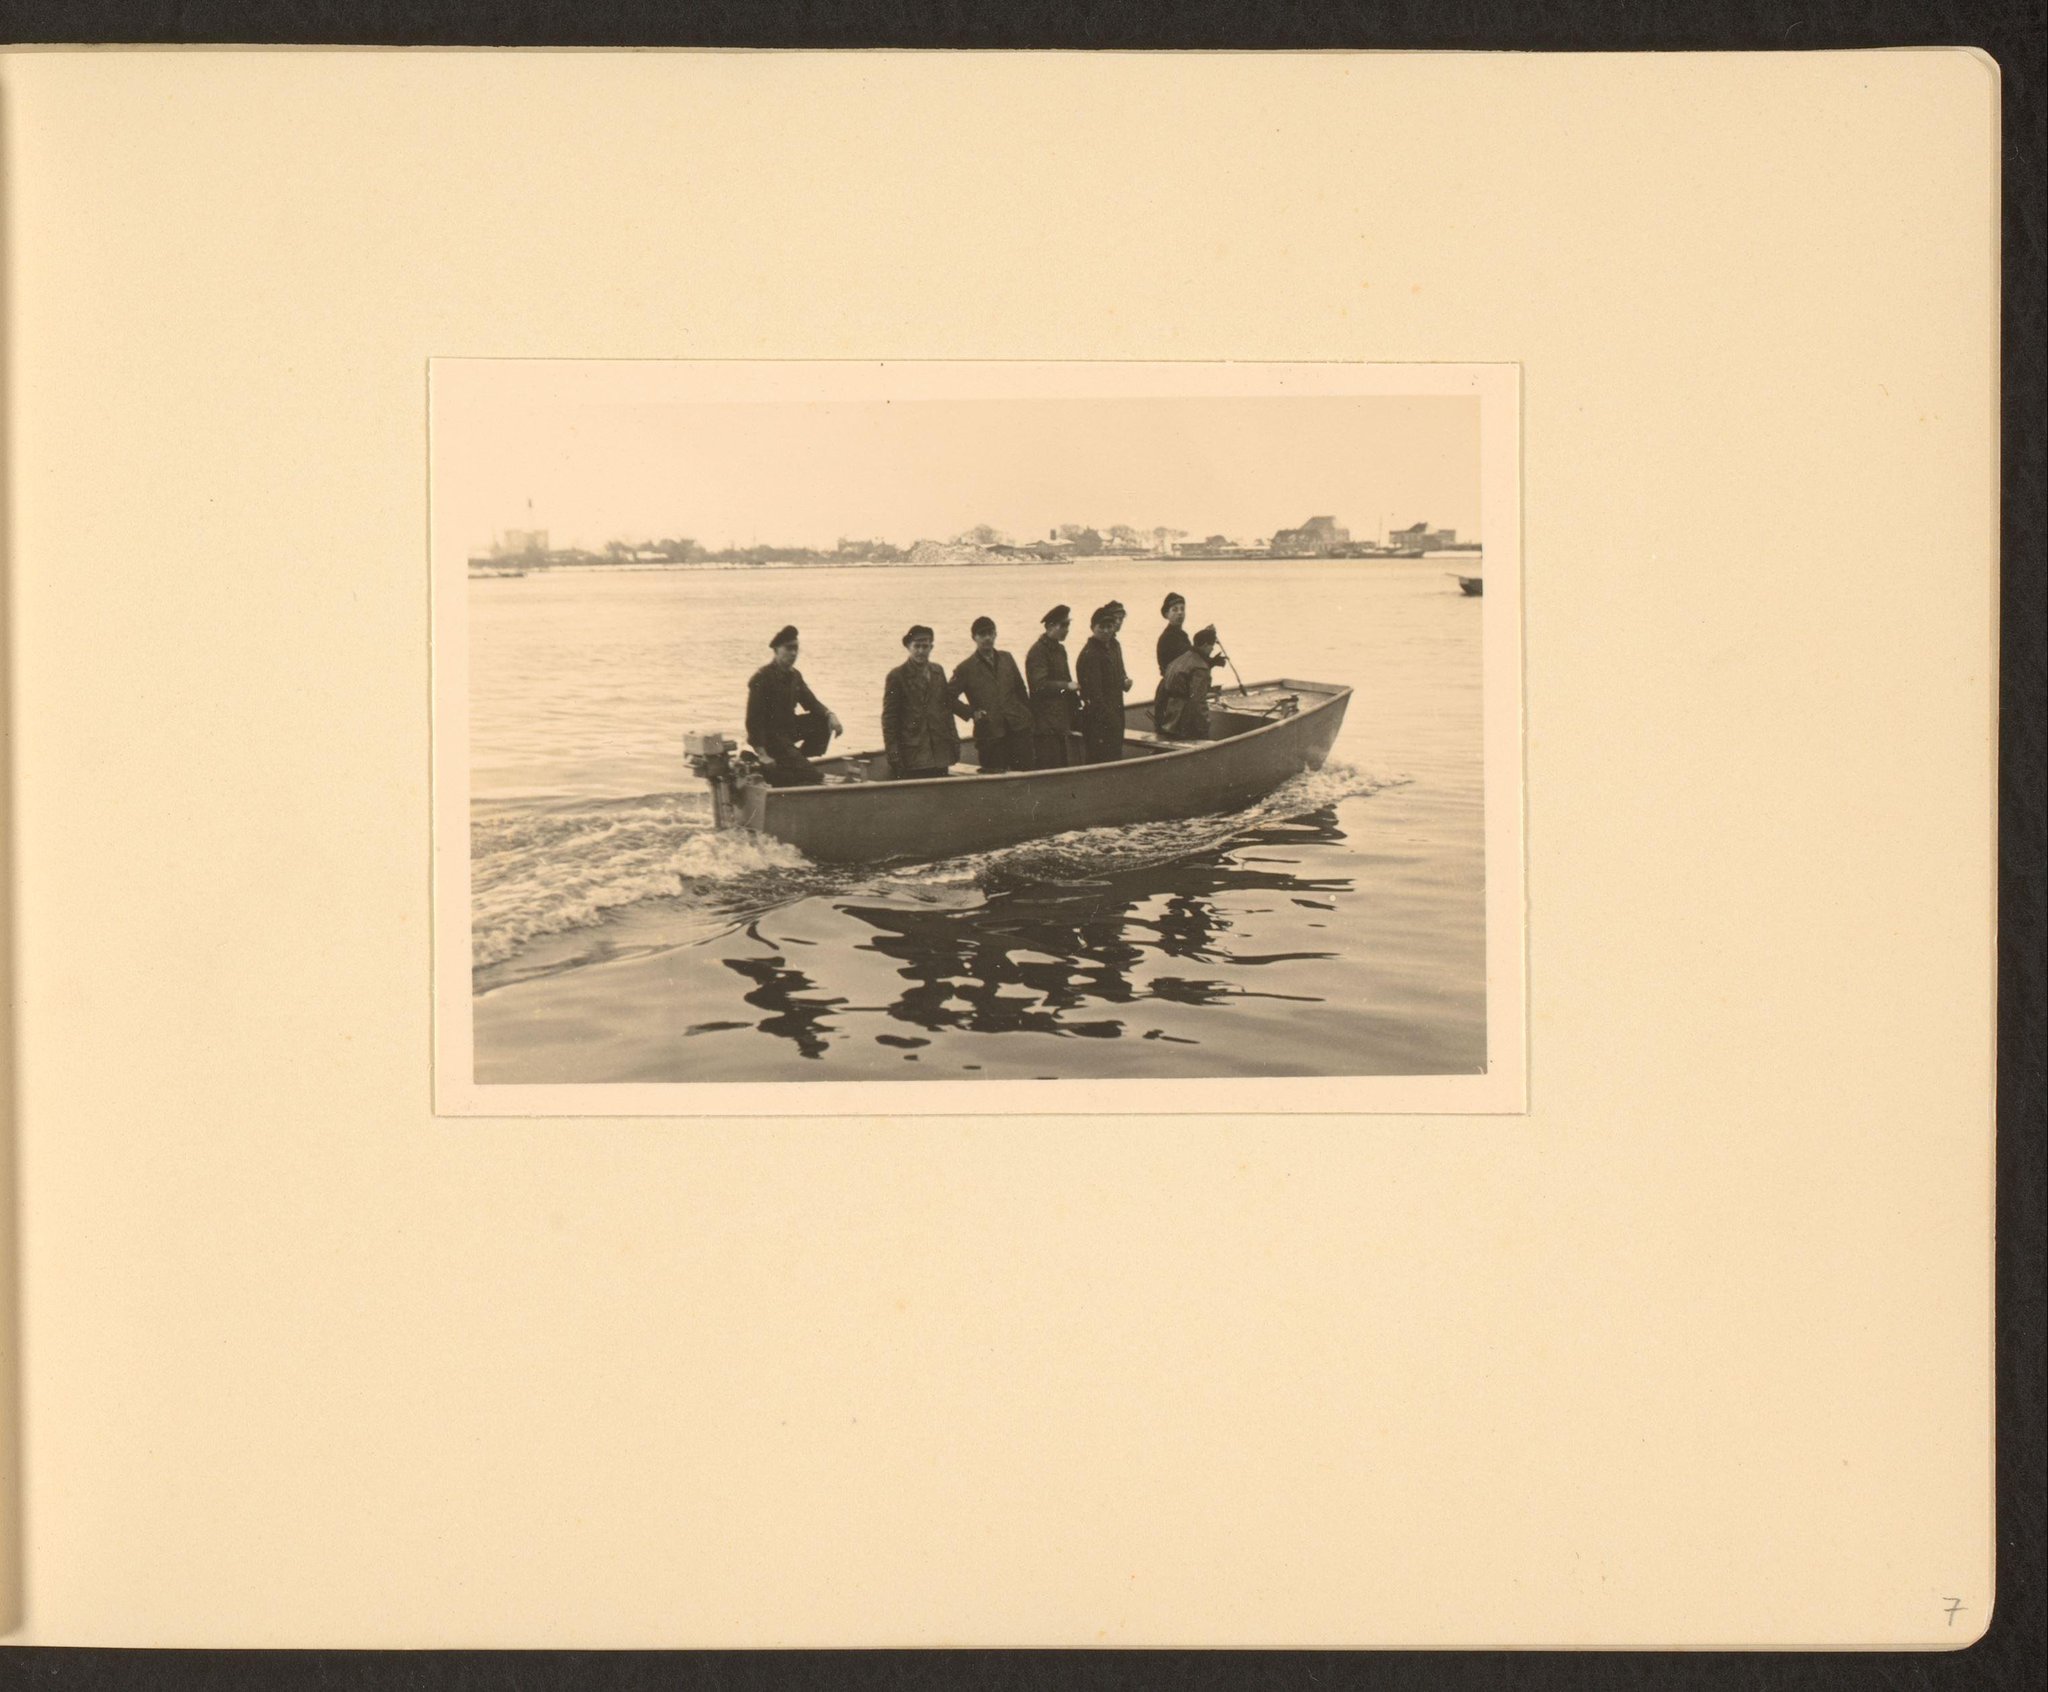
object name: photograph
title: Proefvaart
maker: Anonymous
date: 1902-1953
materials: paper, photographic support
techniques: gelatin silver print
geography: emden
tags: building a ship, ship under construction, pier, quay, wharf, steamship, motorship, north sea flood of 1953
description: Albumblad met een foto waarin een metalen sloep gebouwd door Nordseewerke Emden in het water wordt getest met ca. zeven man aan boord. Onderdeel van het fotoalbum 'Emden hilft Holland'.